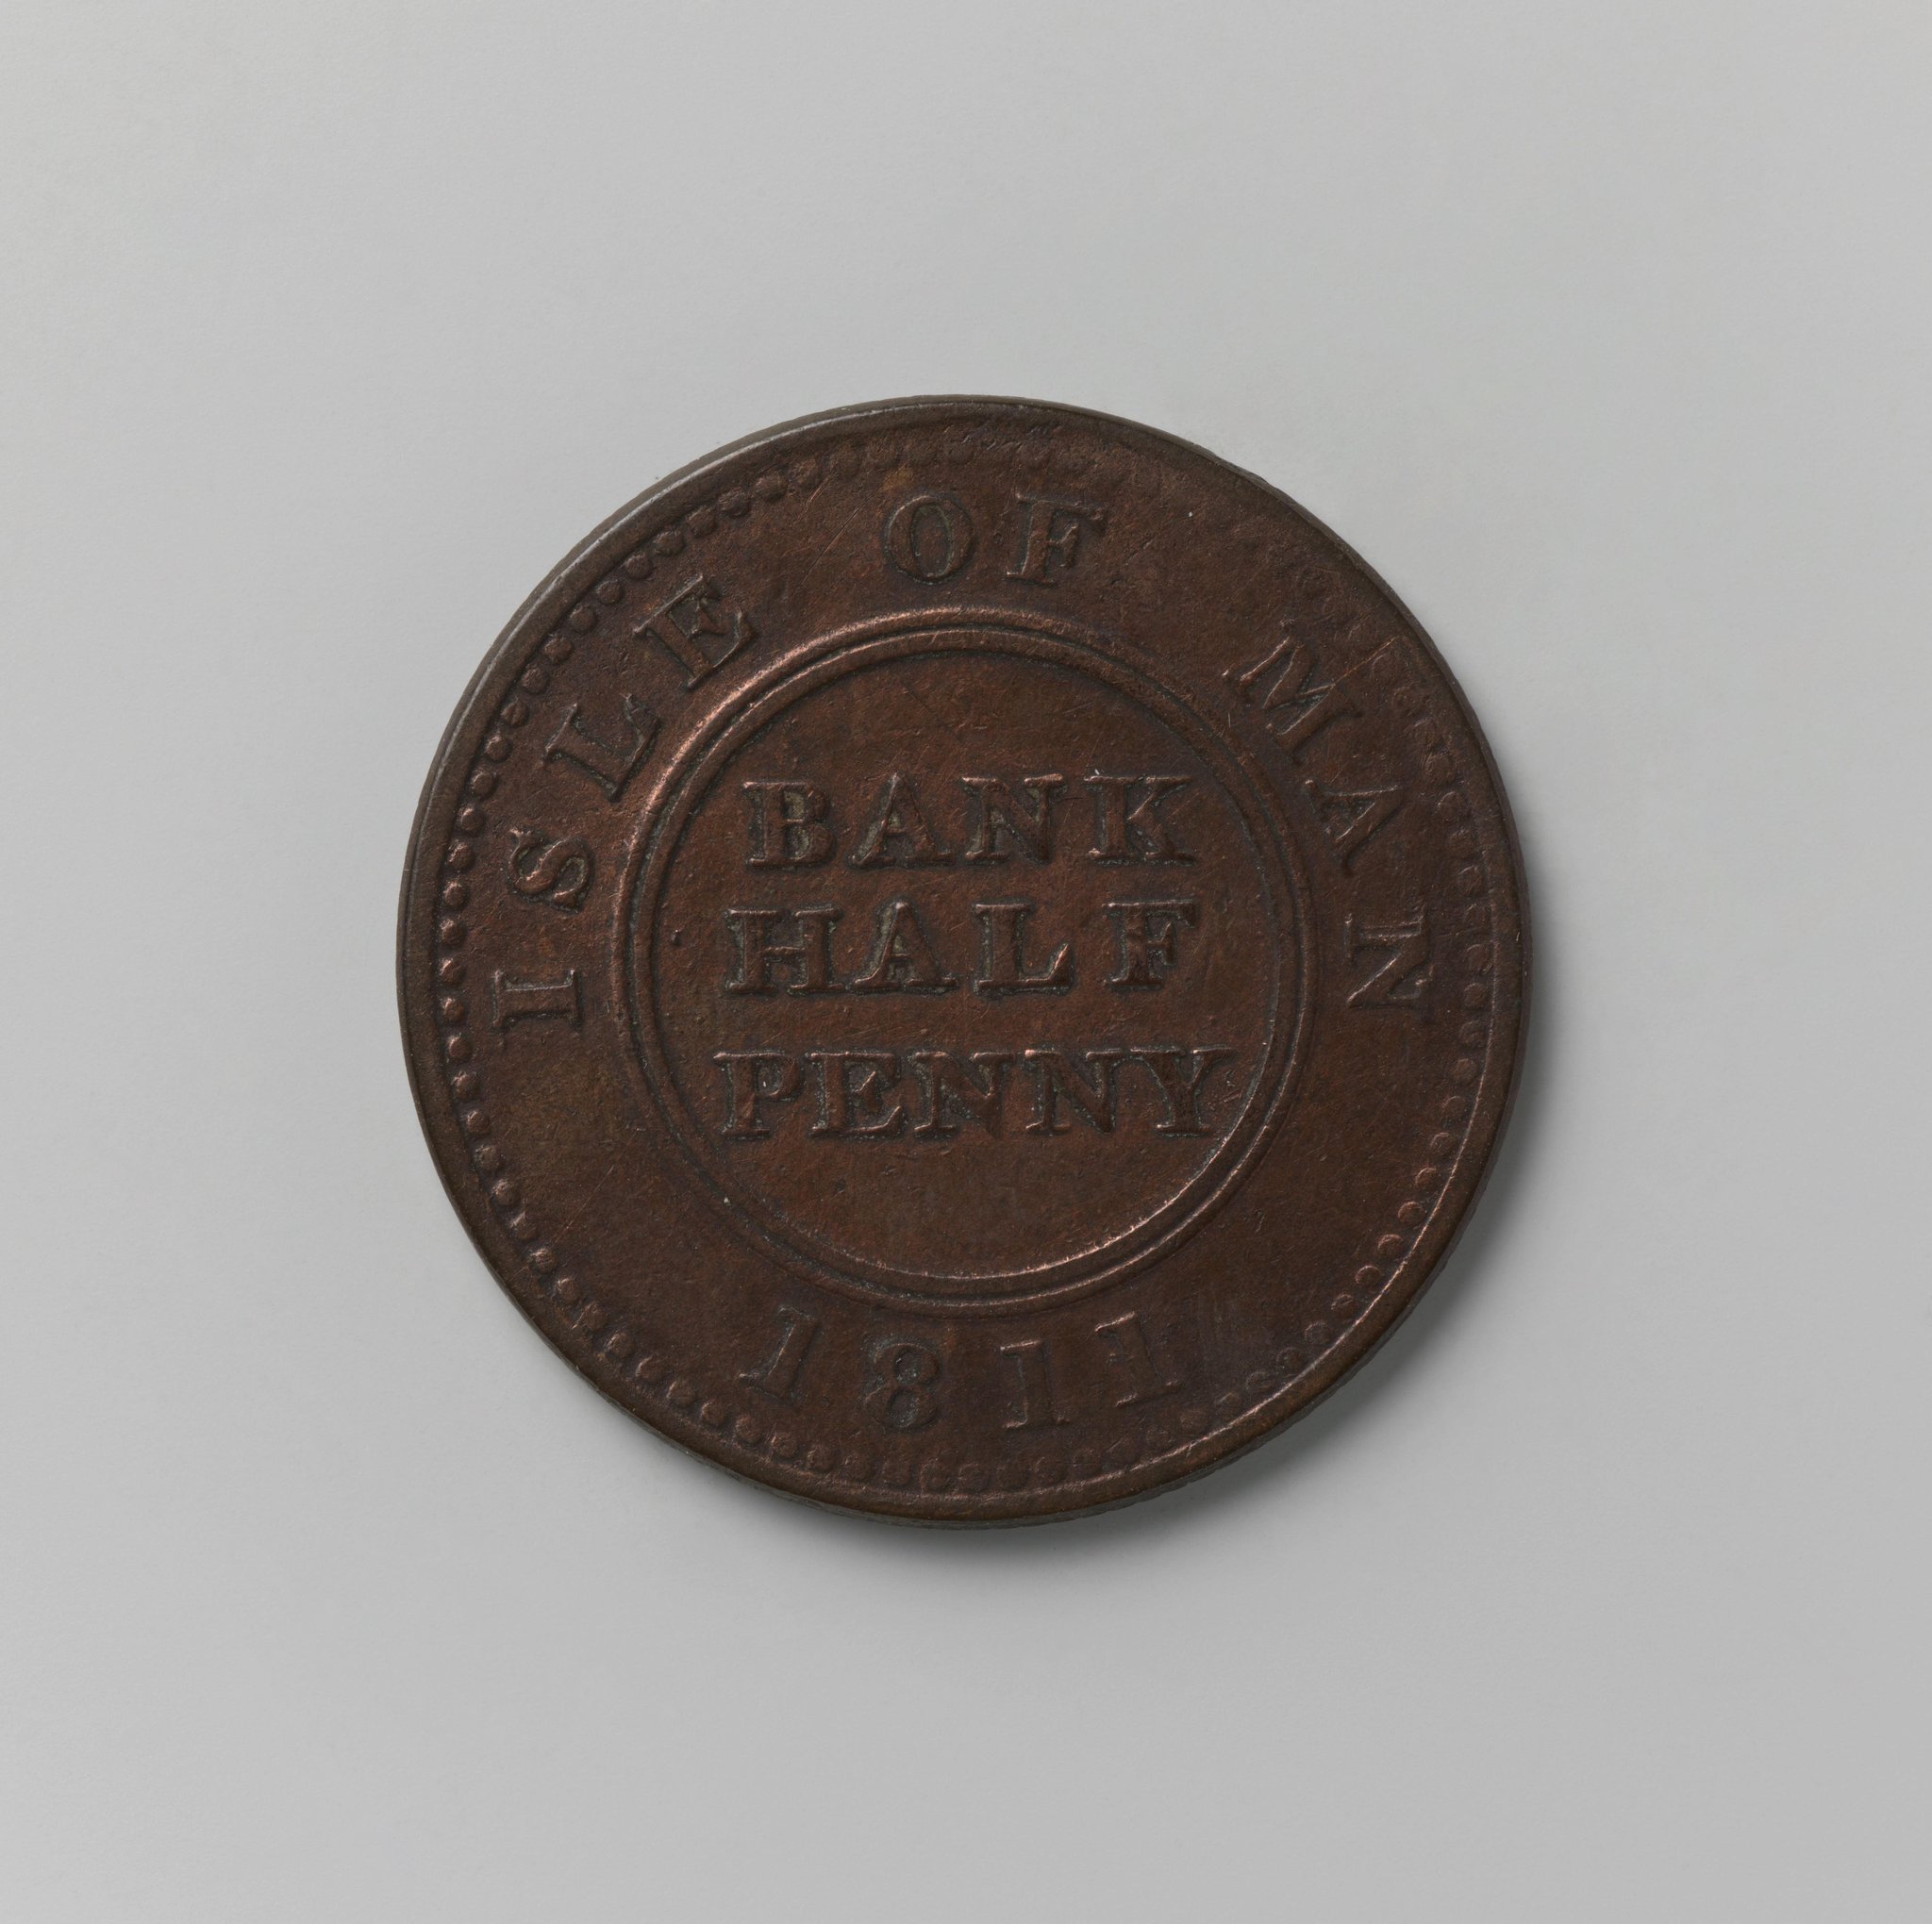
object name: halve penny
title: betaalpenning (token) voor halve penny uit het eiland Man, 1811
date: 1811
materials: copper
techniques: striking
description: Koperen particuliere munt. Voorzijde: driebenig symbool van Man. Keerzijde: in drie regels waarde-aanduiding. Onderaan jaartal. Kartelrand.